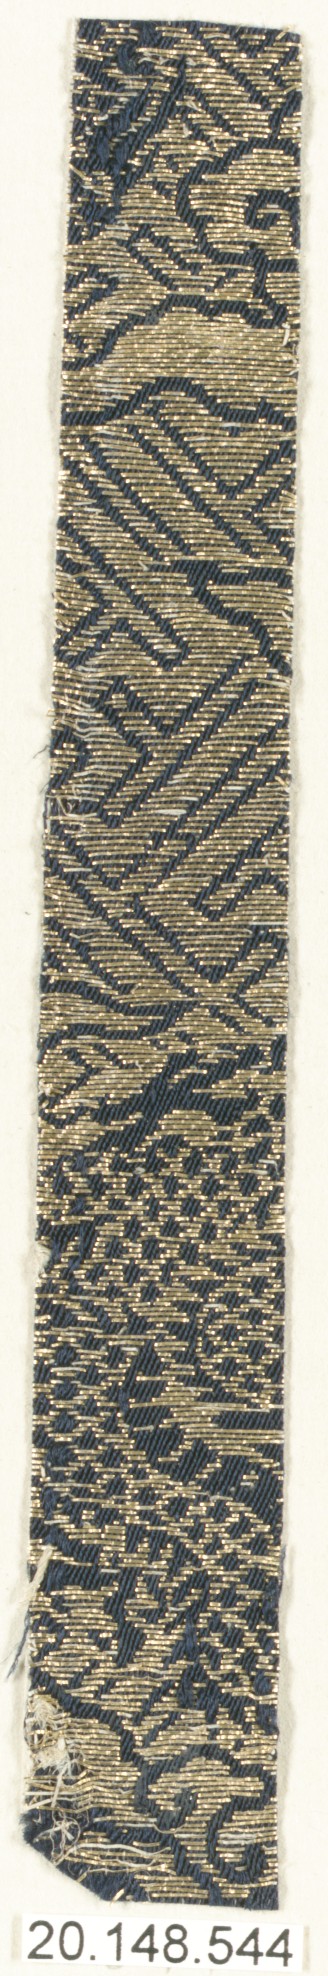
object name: piece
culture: chinese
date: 1701-1800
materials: silk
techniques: compound weave